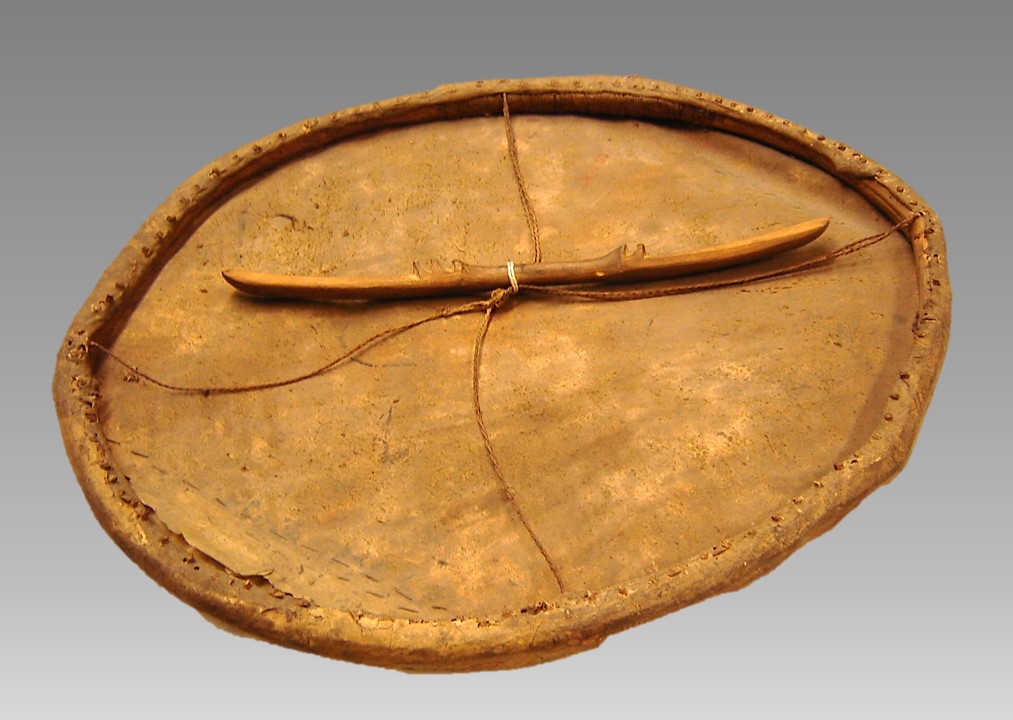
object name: kazo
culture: japanese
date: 1801-1900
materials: wood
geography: japan